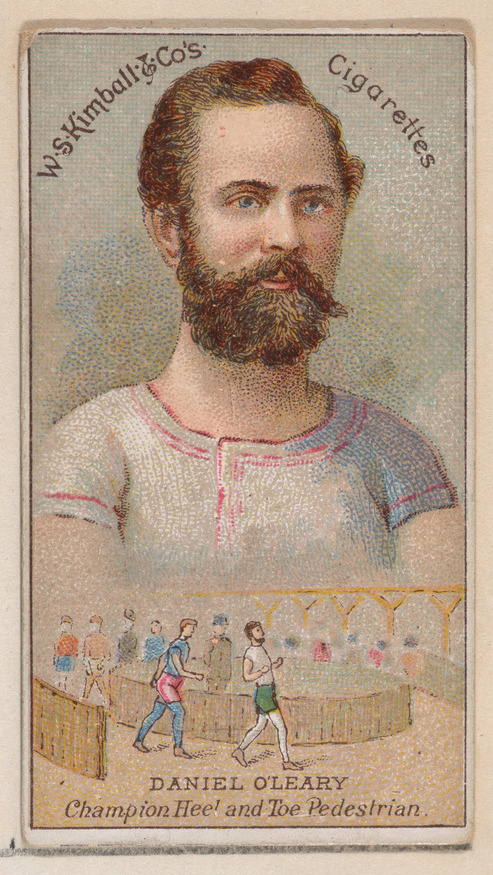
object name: print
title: Daniel O'Leary, Champion Heel and Toe Pedestrian, from the Champions of Games and Sports series (N184, Type 1) issued by W.S. Kimball & Co.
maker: w.s. kimball & co.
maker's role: publisher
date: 1887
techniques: color lithograph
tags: men